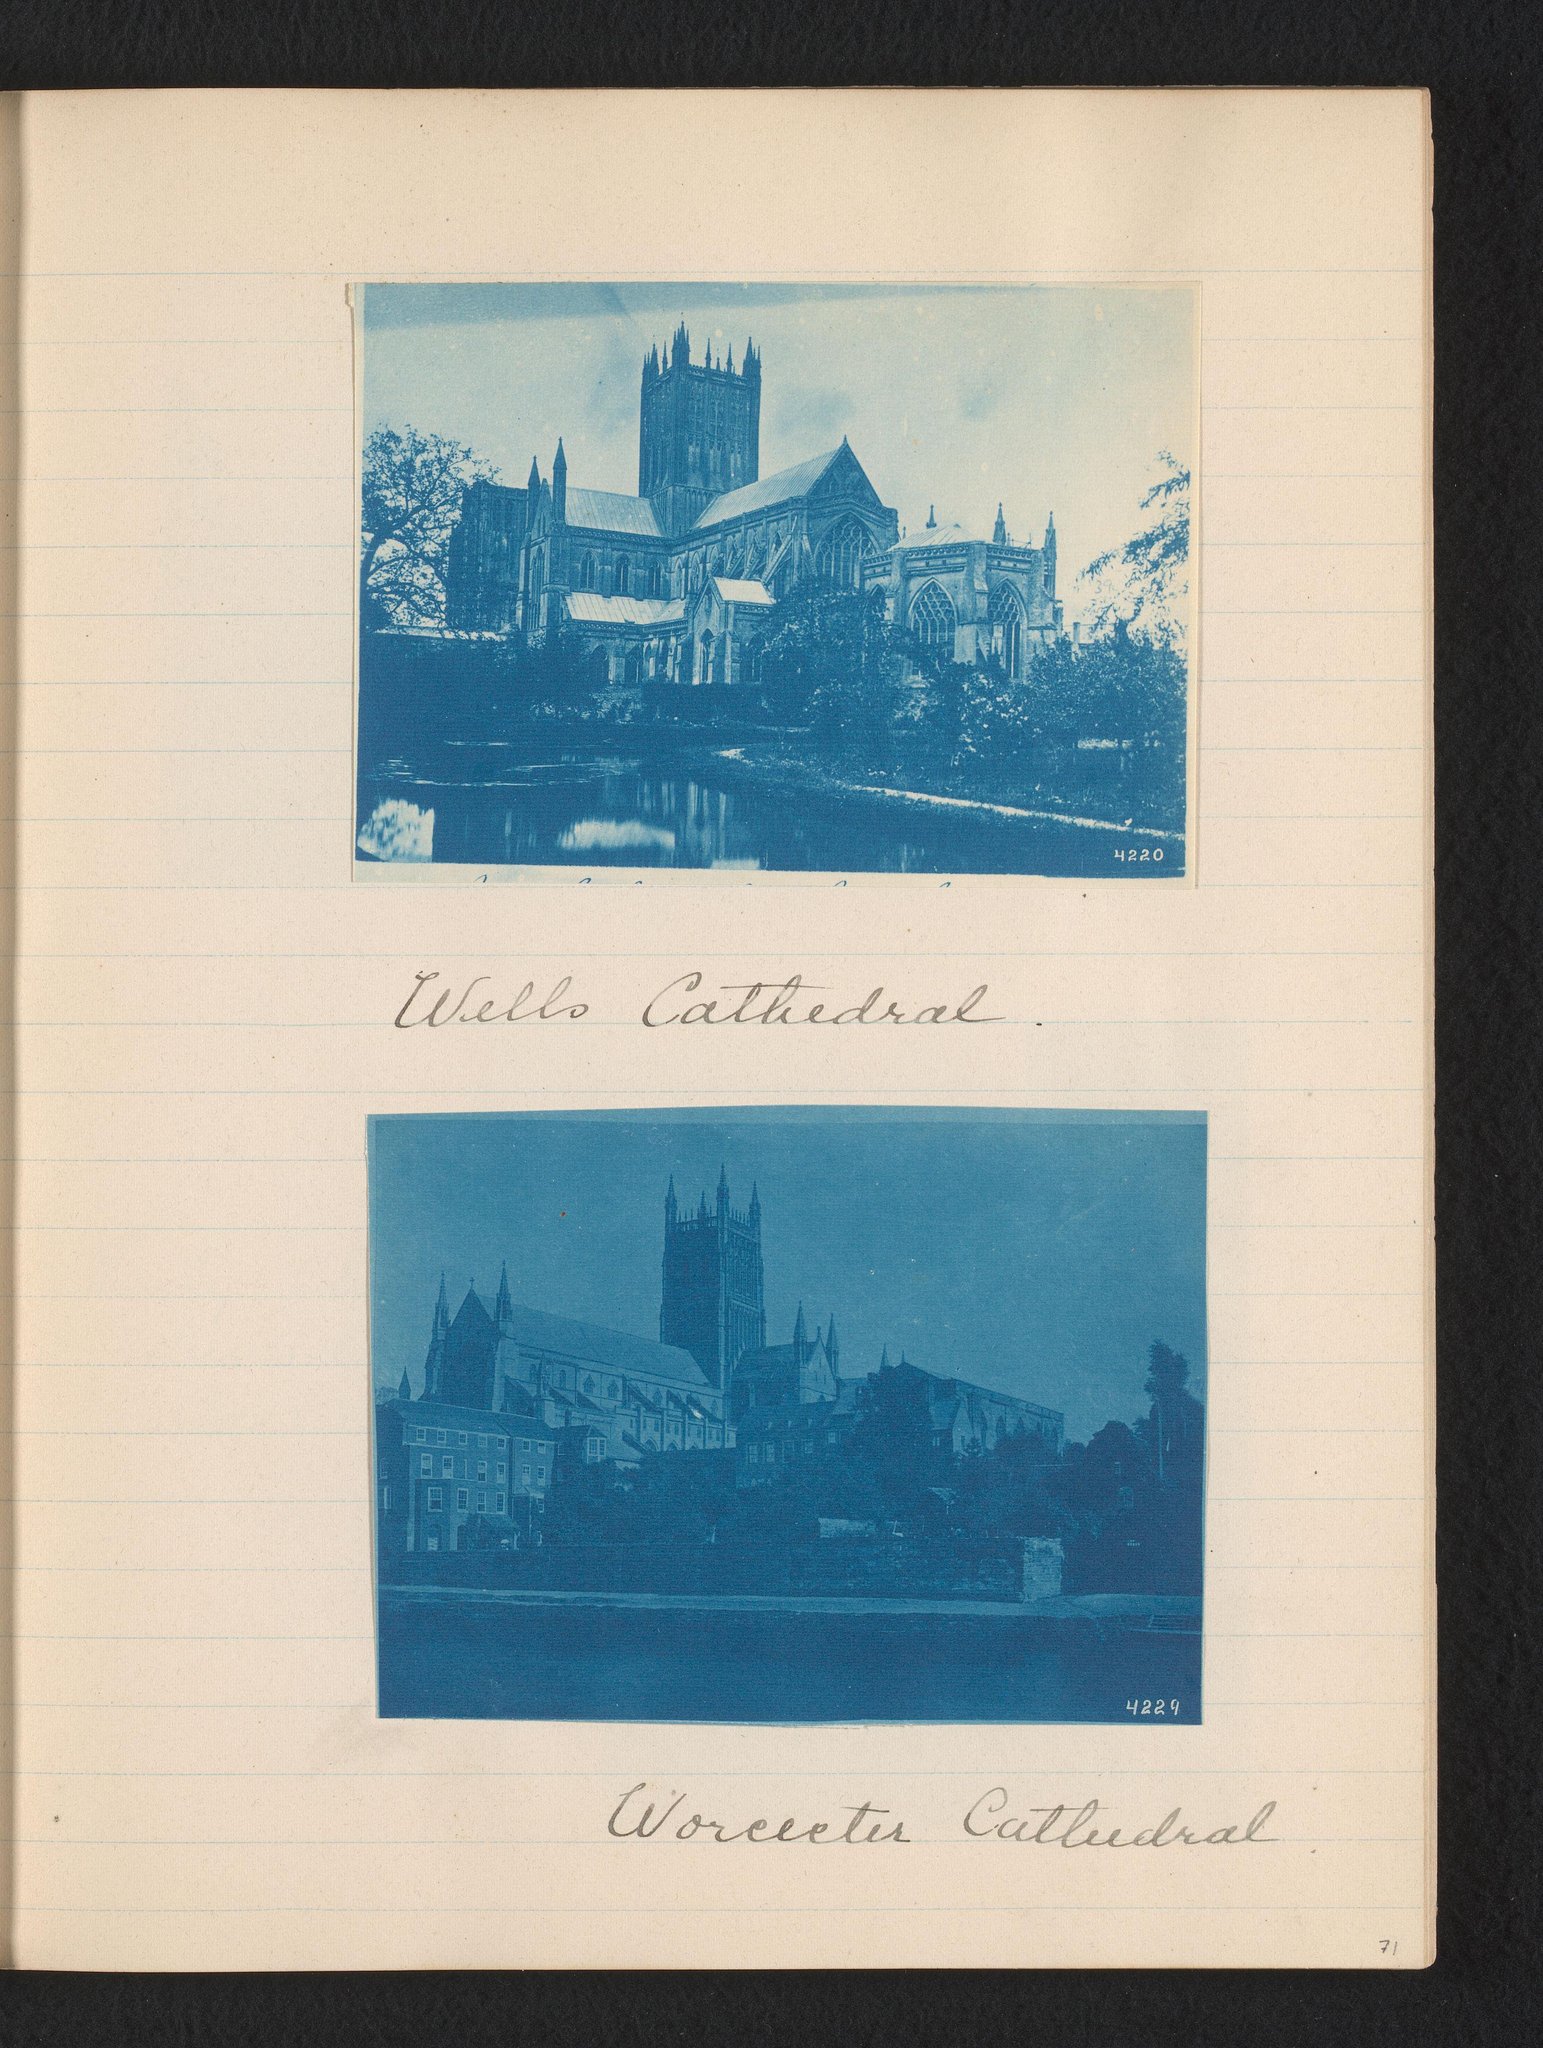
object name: album leaf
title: Twee foto's van de kathedralen van Wells en Worcester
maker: Anonymous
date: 1901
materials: paper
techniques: cyanotype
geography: england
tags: church (exterior)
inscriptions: inscription: ‘Warwick Castle./ St Mary's Church, Warwick.’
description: Deze foto's maken deel uit van een album.